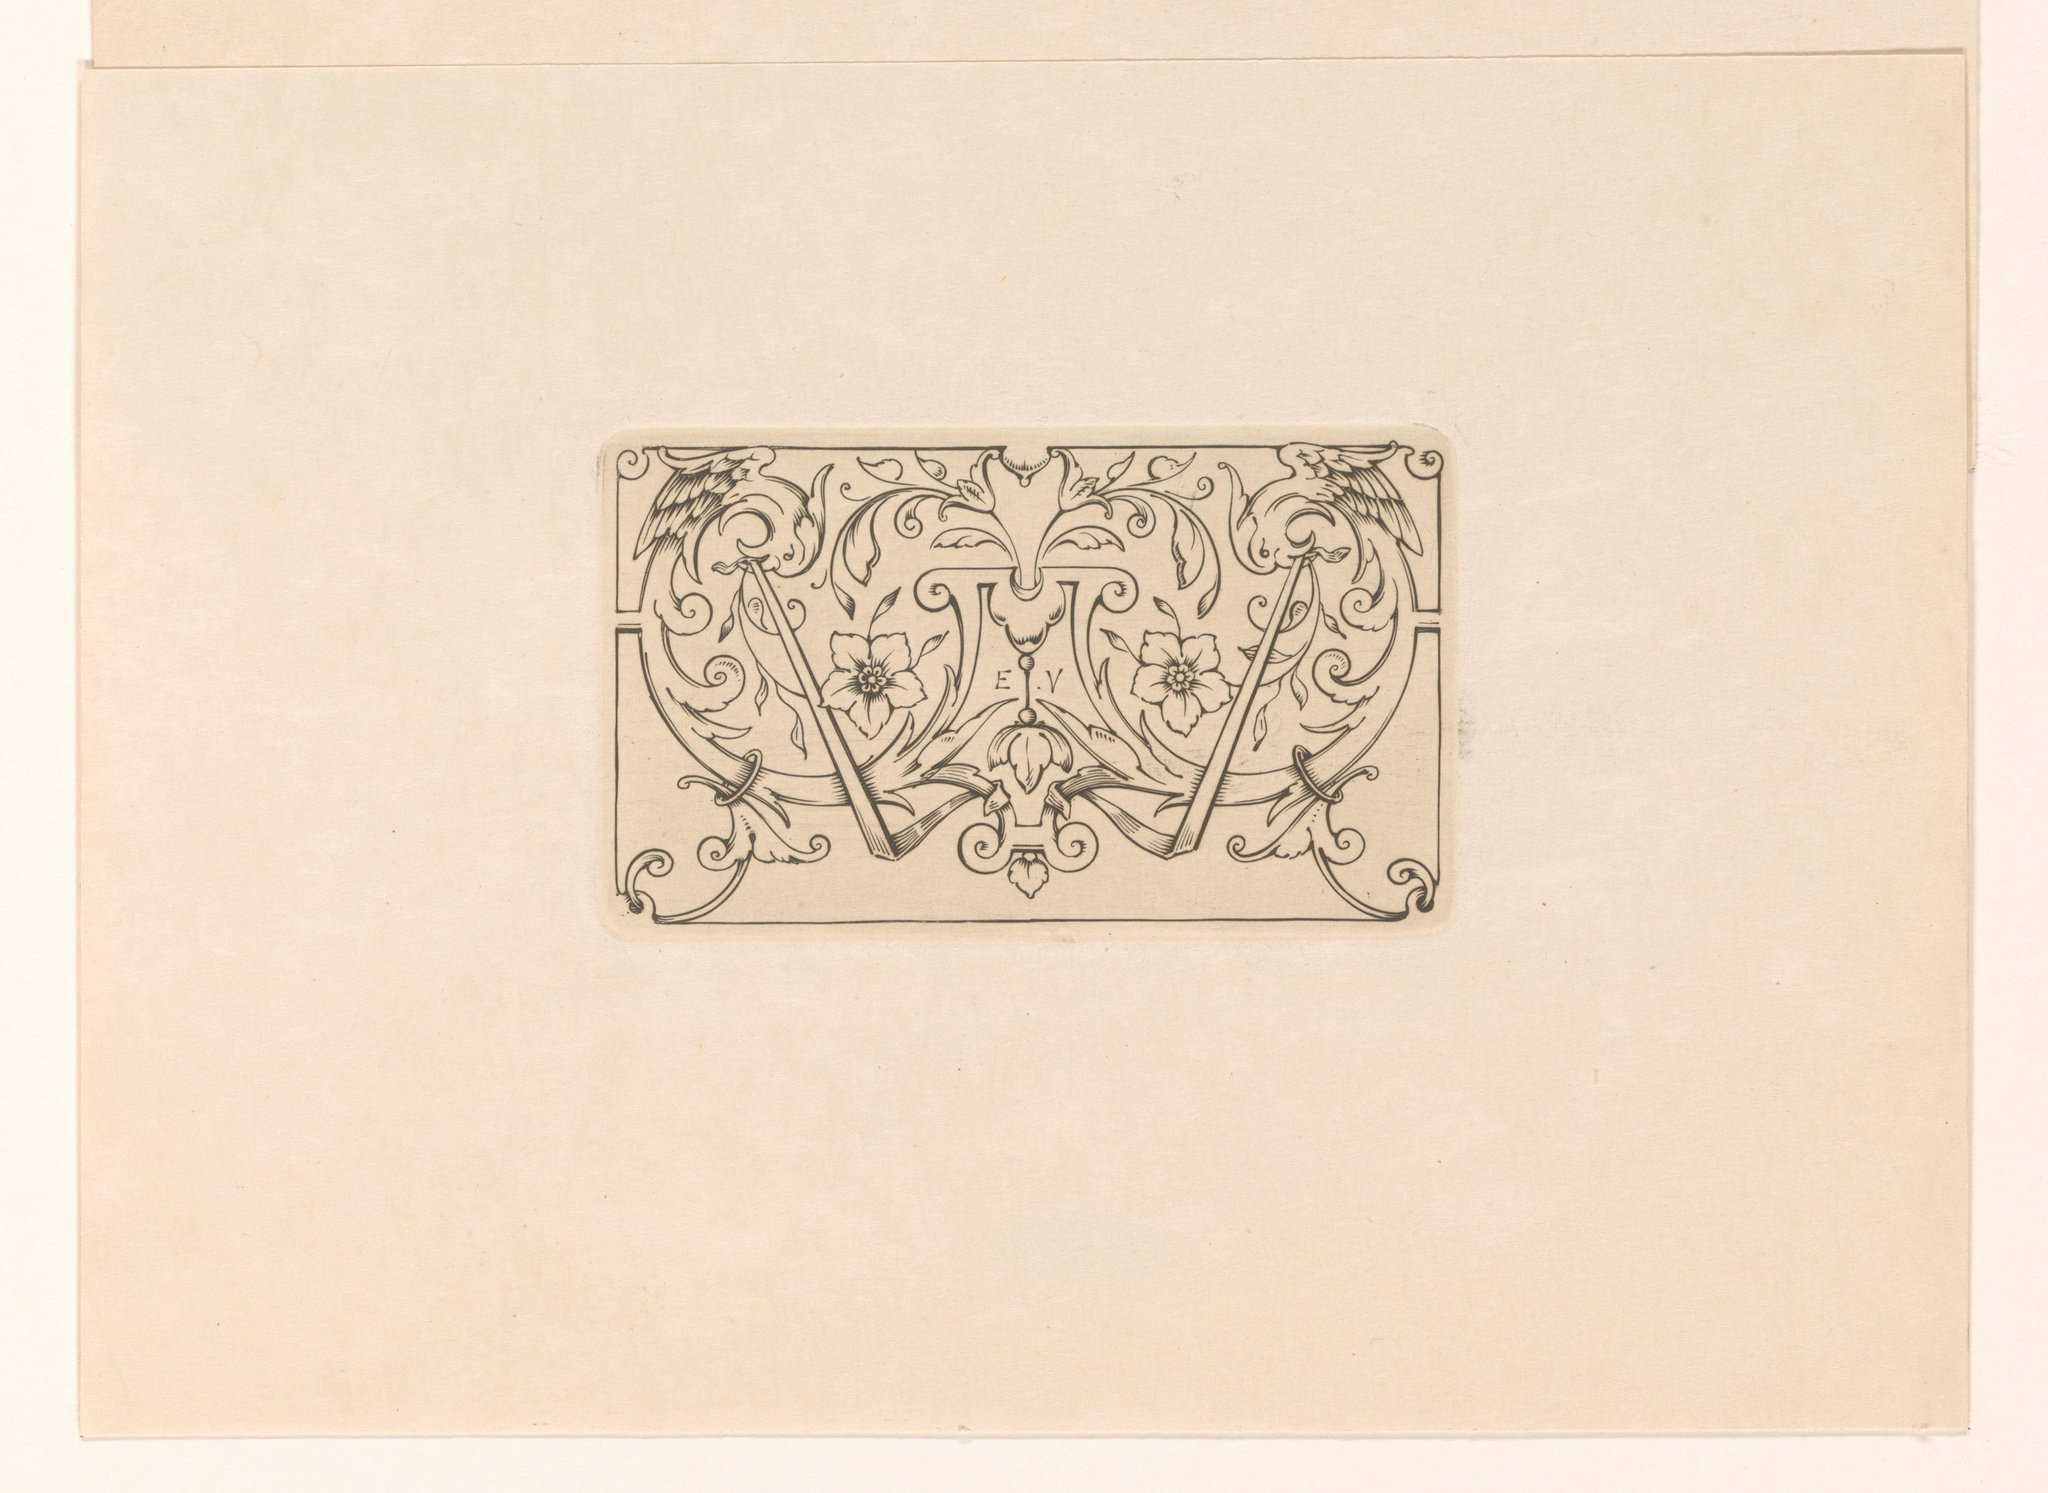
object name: print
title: Vignet met bloemen en vogels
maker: elias voet jr.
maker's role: jeweler, print maker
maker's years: 1868-1940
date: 1878-1940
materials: paper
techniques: engraving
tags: flowers, birds, vignette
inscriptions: collector's mark: Lugt 2228